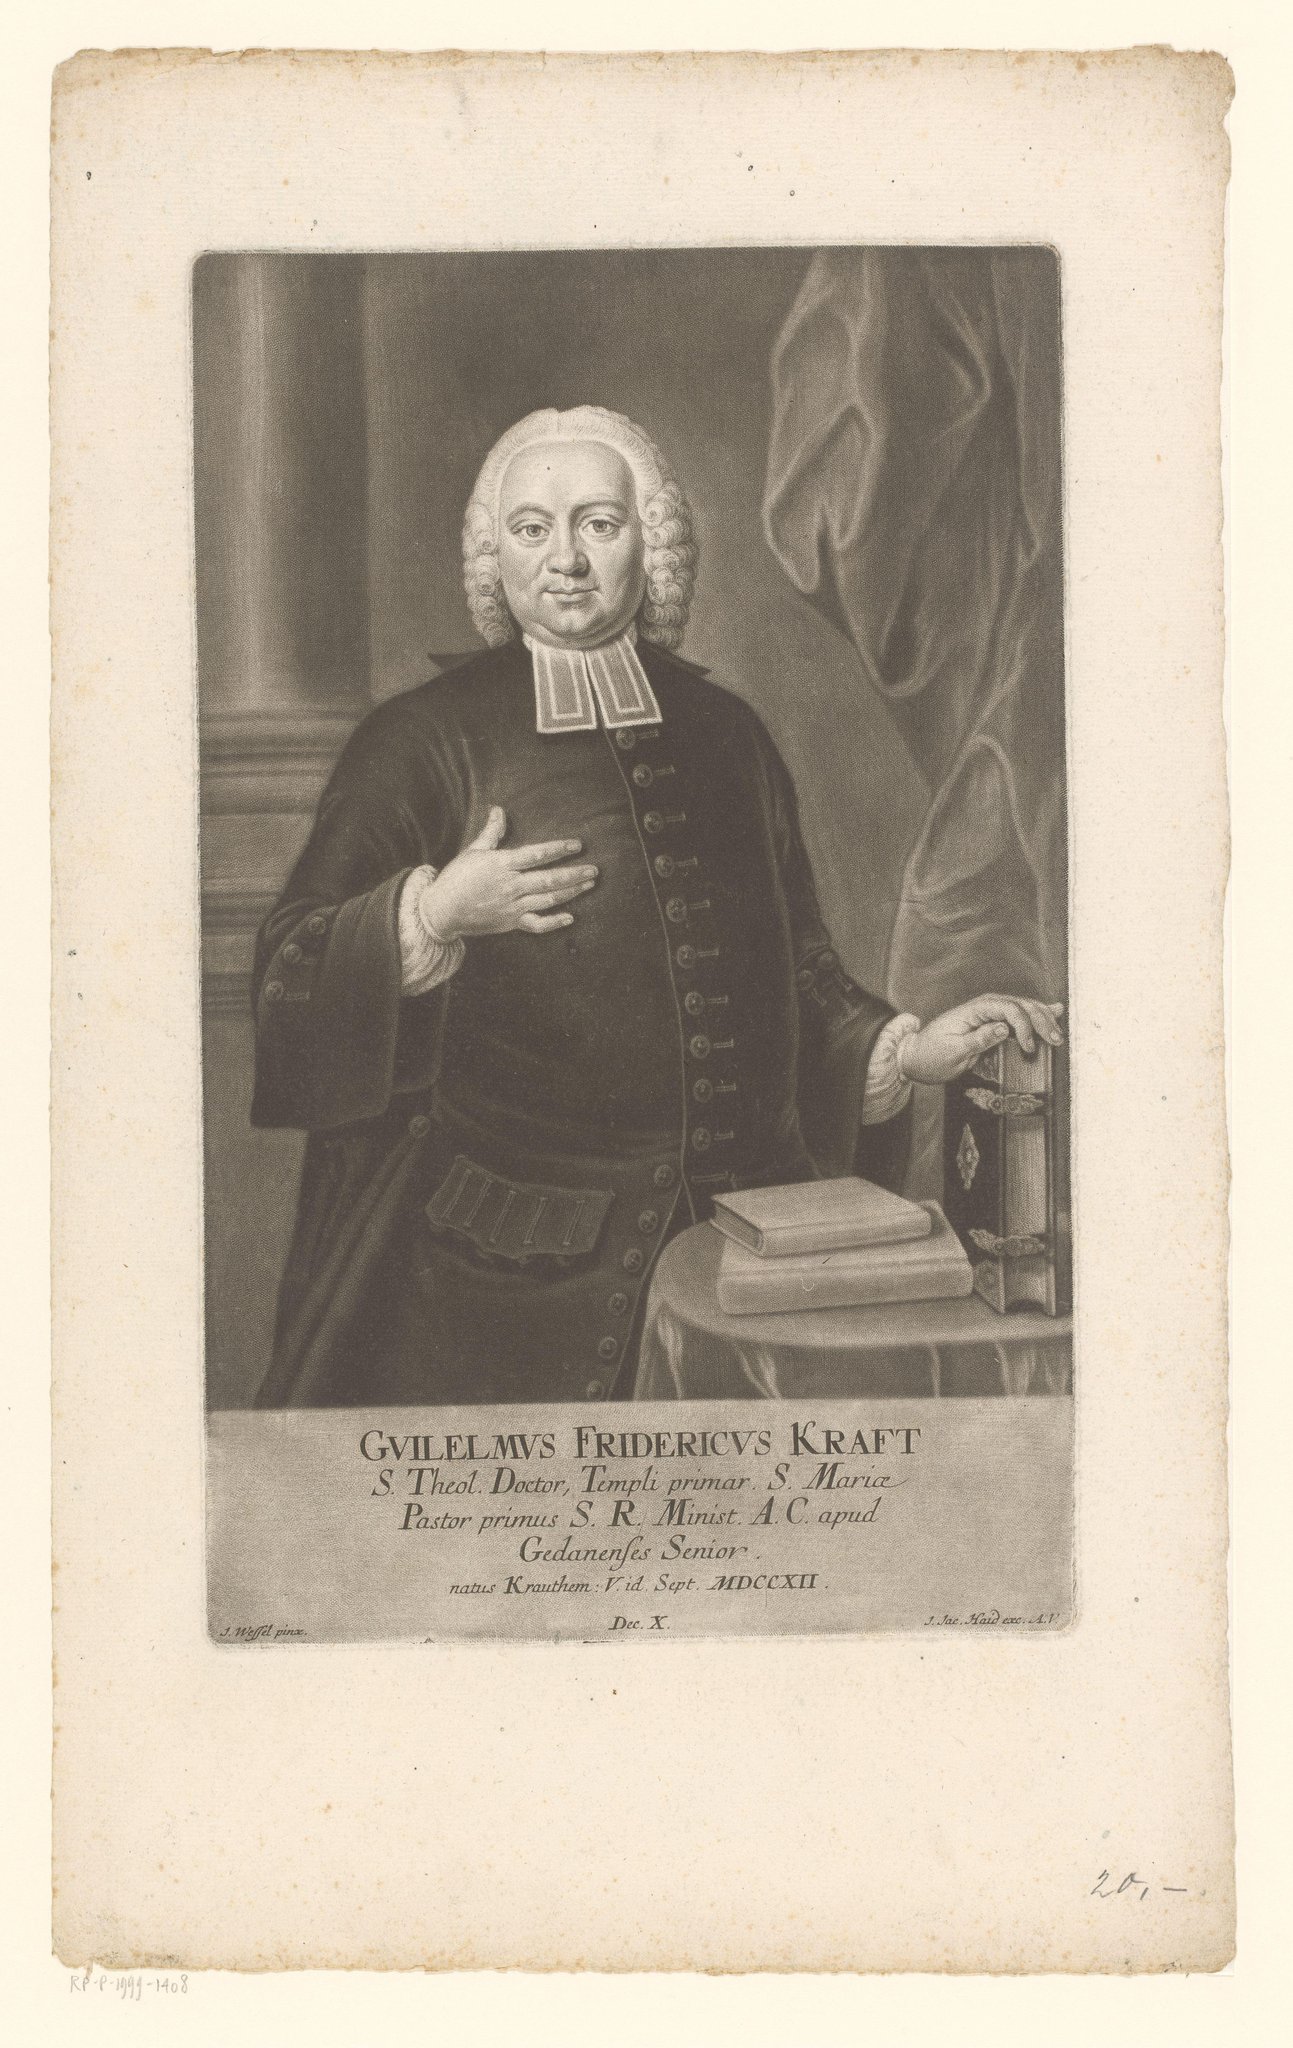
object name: print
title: Portret van Friedrich Wilhelm Kraft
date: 1755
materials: paper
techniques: mezzotint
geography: augsburg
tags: theologian, historical persons, book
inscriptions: collector's mark: Lugt 2228, collector's mark: Lugt 2760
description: Prent gebruikt voor: Brucker, Jacob. Bildersal heutiges Tages lebender und durch Gelahrheit berühmter Schrifftsteller. Augsburg: Johann Jacob Haid, 1755.